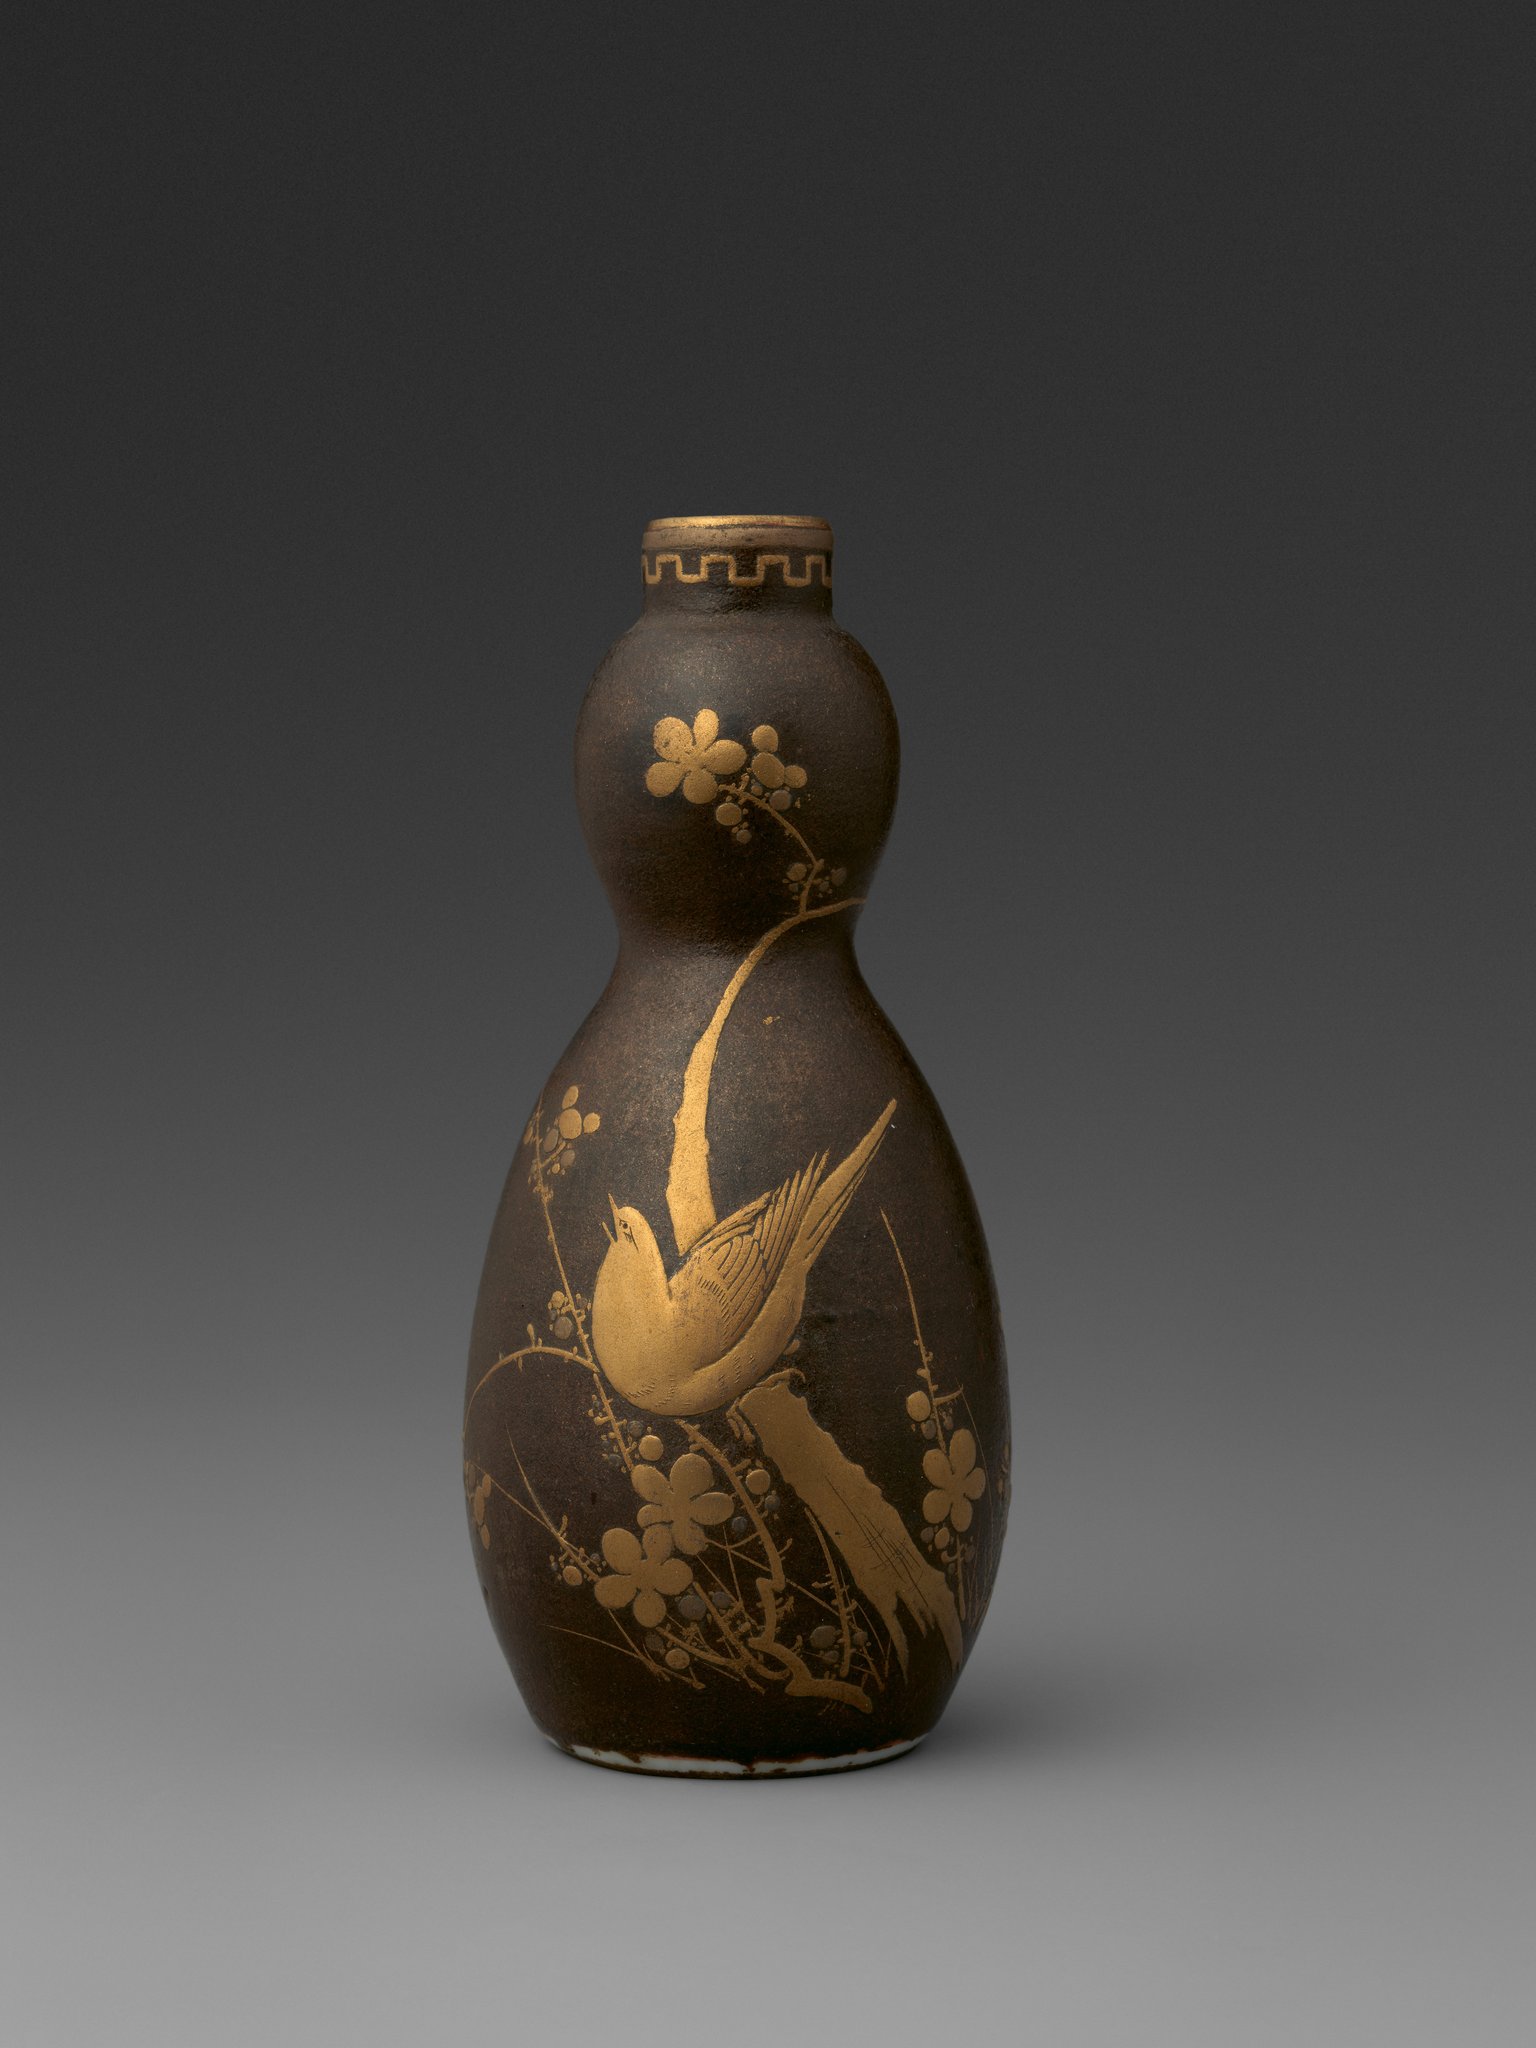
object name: bottle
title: Sake Bottle (Tokkuri)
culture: japanese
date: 1834-1866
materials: enamel, gold, porcelain, silver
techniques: hiramakie, overglaze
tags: birds,flowers